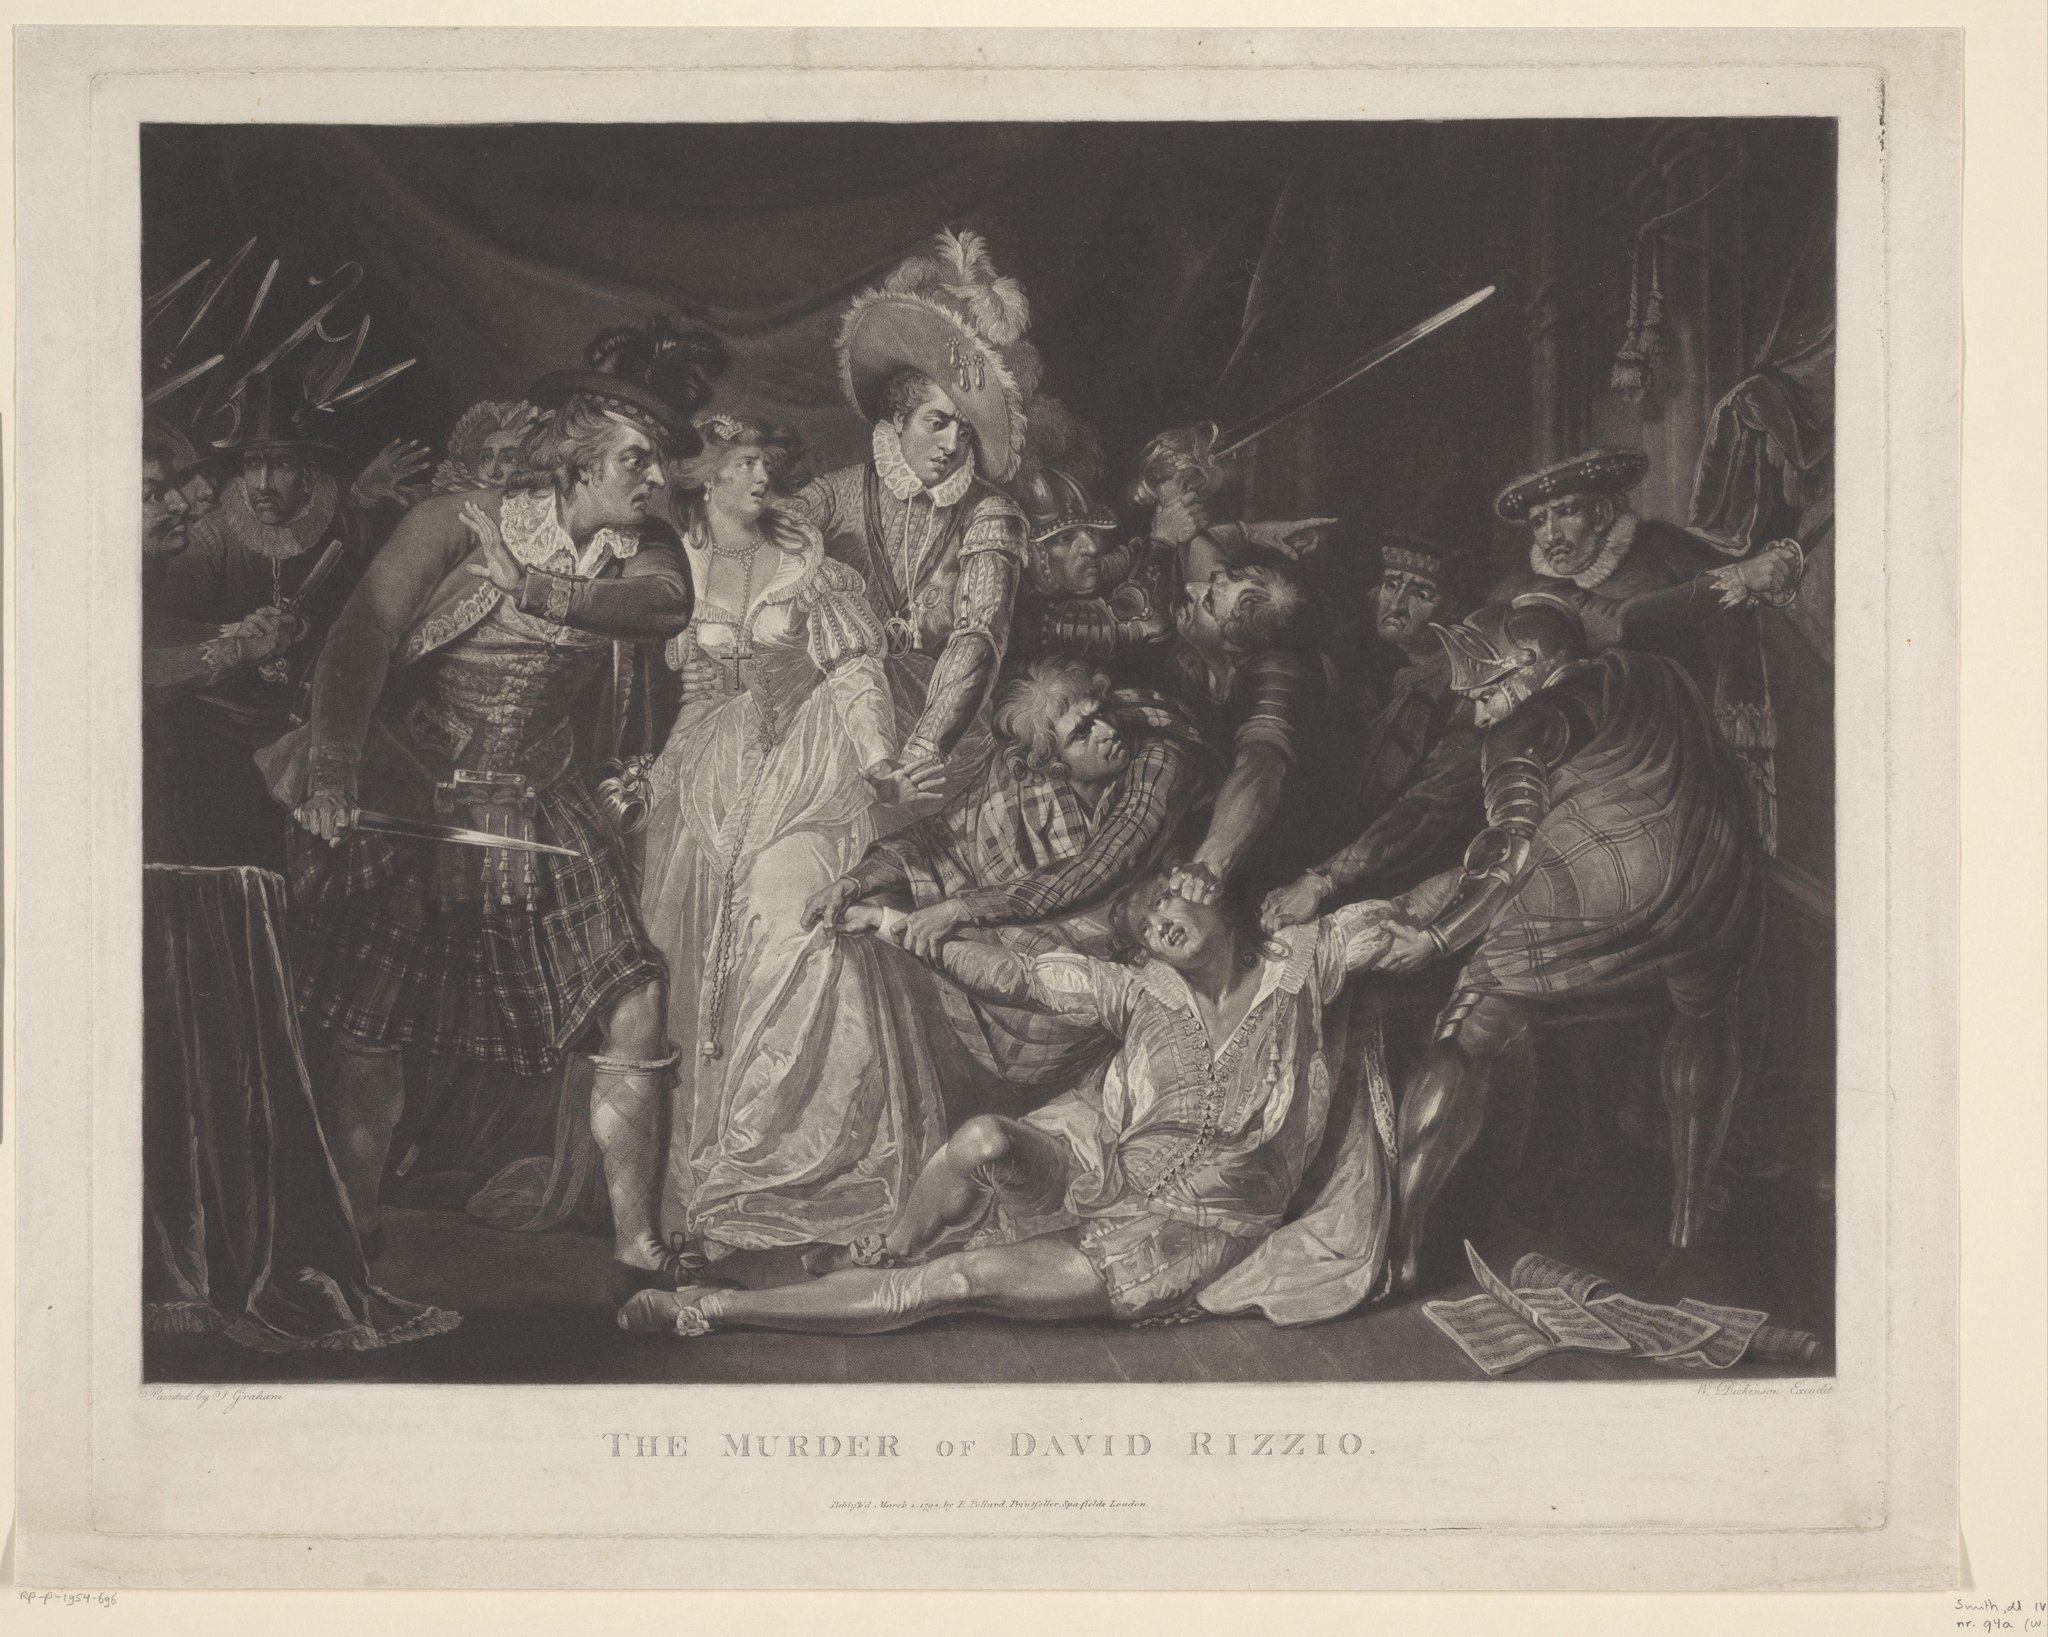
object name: print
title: Moord op David Rizzio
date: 1791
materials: paper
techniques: mezzotint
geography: london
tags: historical persons, hacking and thrusting weapons: sword, murder, royal household; courtiers, retinue, train - bb - female ruler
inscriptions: collector's mark: Lugt 2760, collector's mark: Lugt 2228